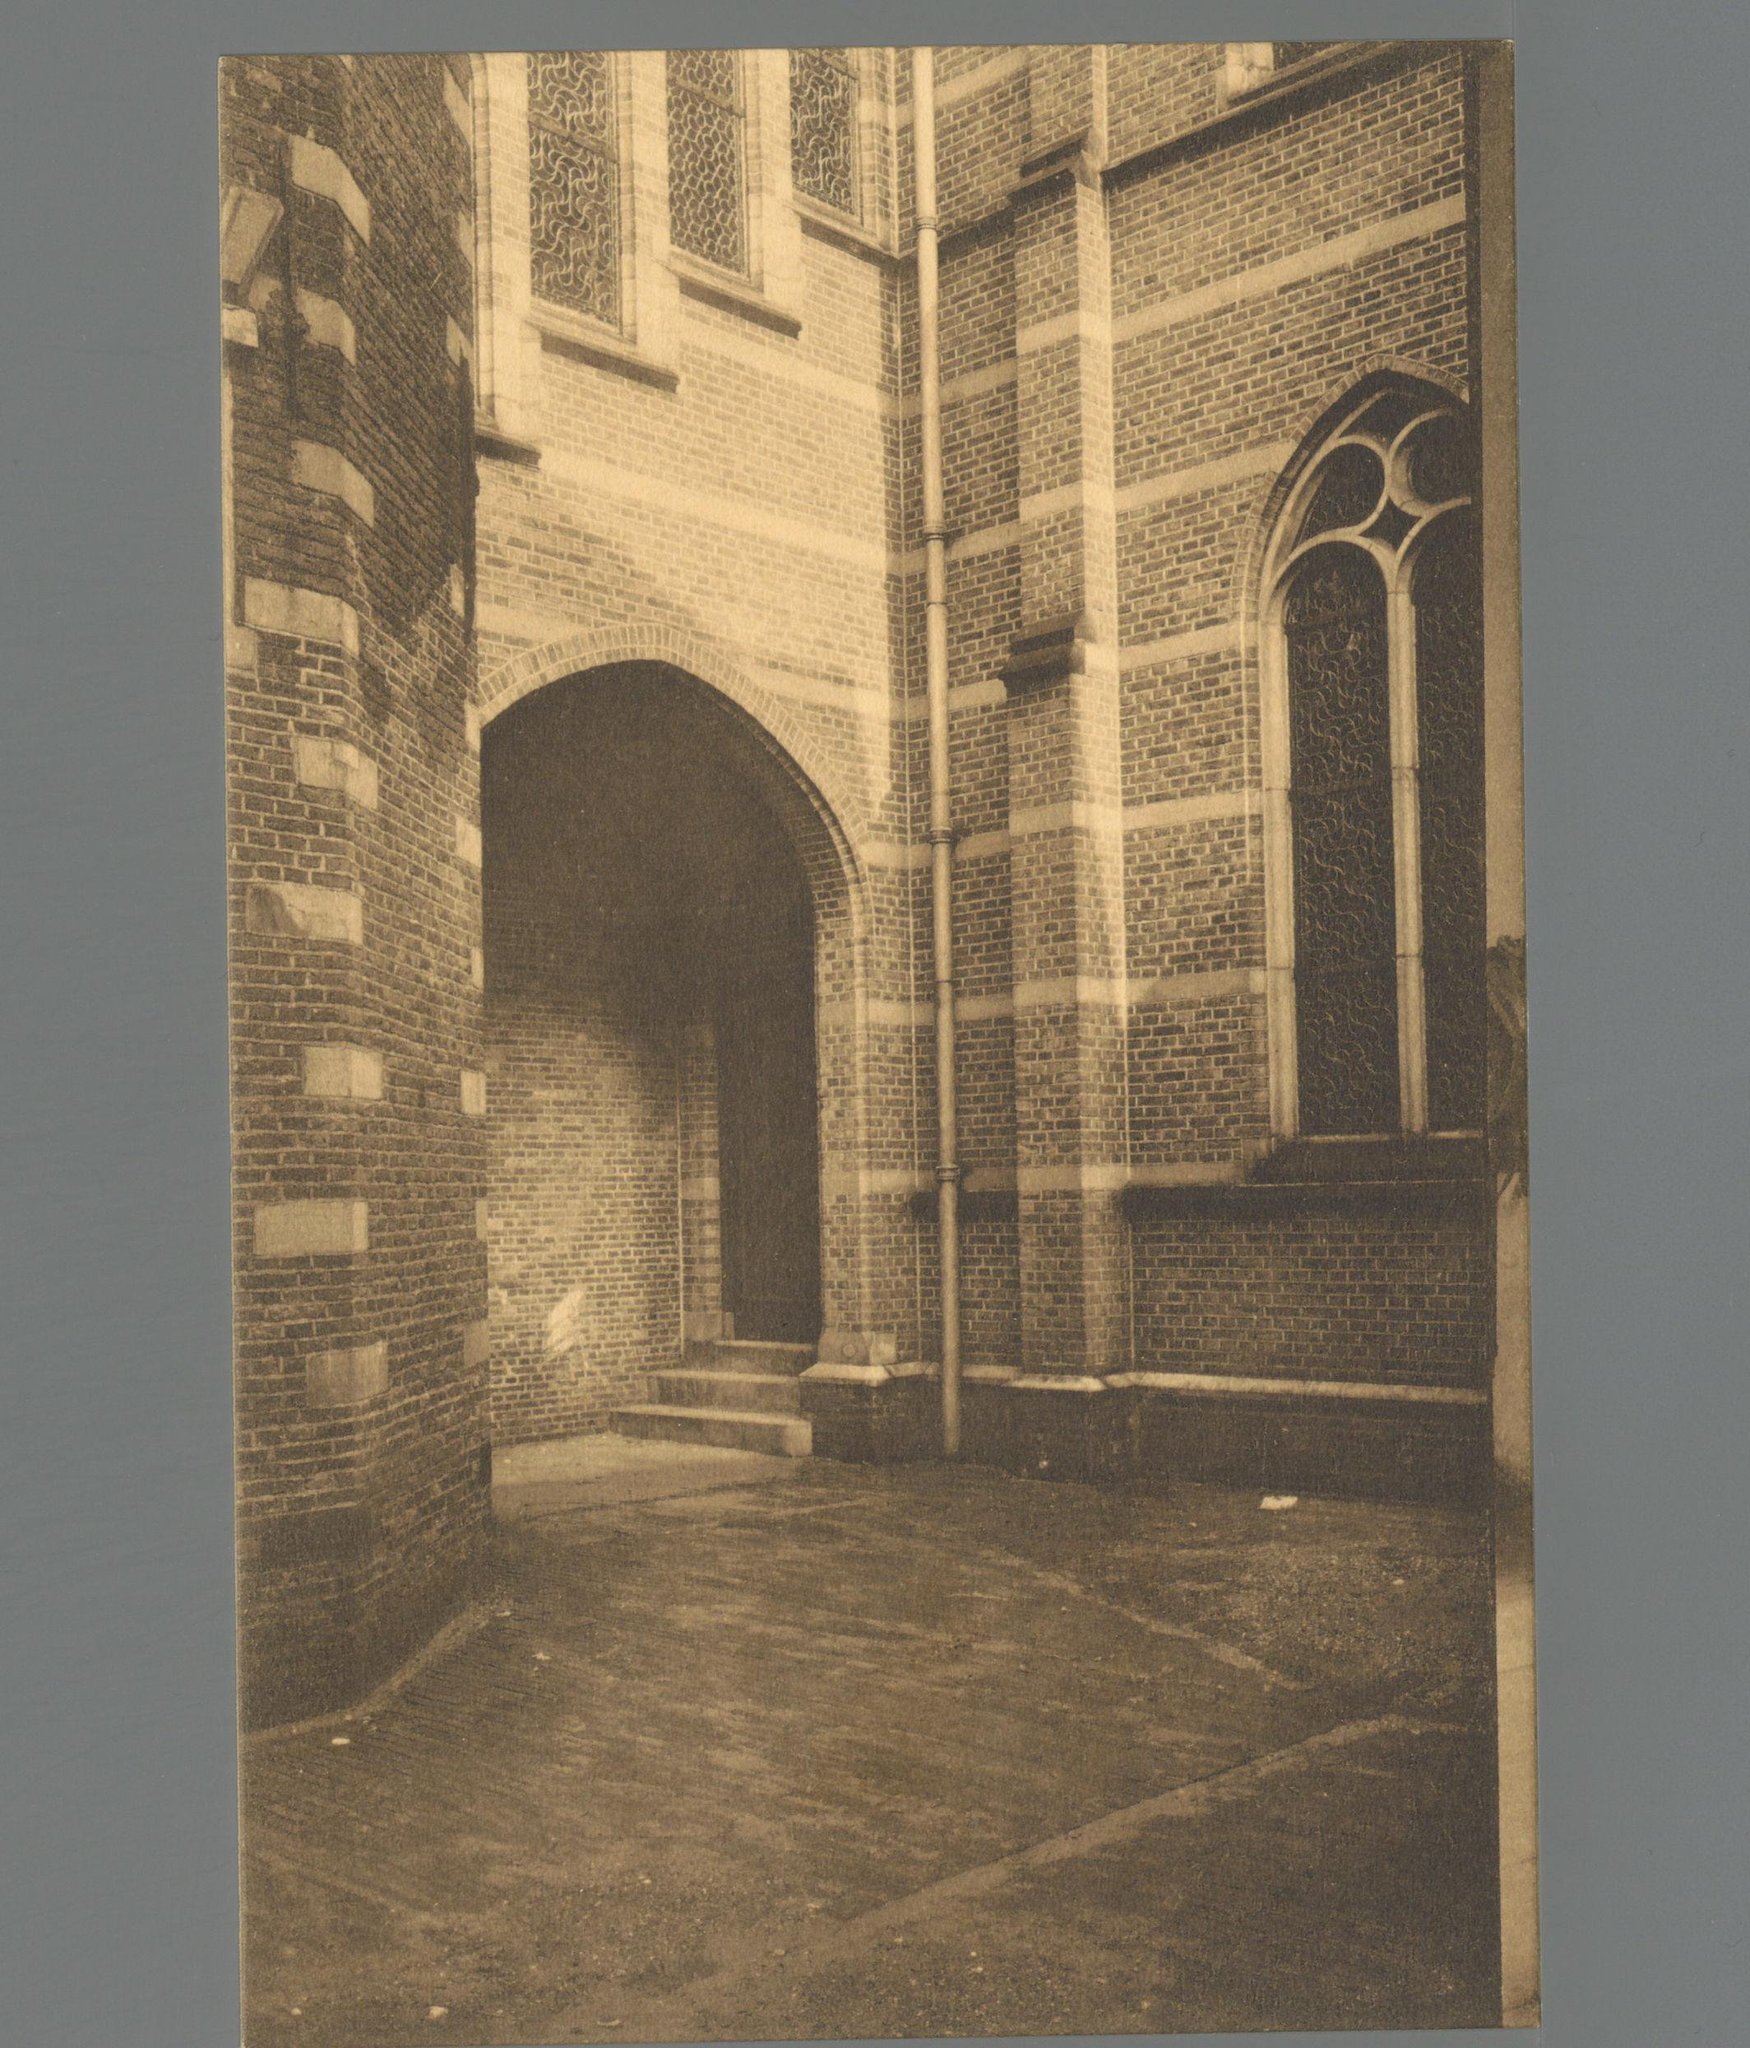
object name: photomechanical print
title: Leiden. Binnenplaats. Rapenburg No. 25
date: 1905-1930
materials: cardboard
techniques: photograph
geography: leiden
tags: university building, college, courtyard, leiden